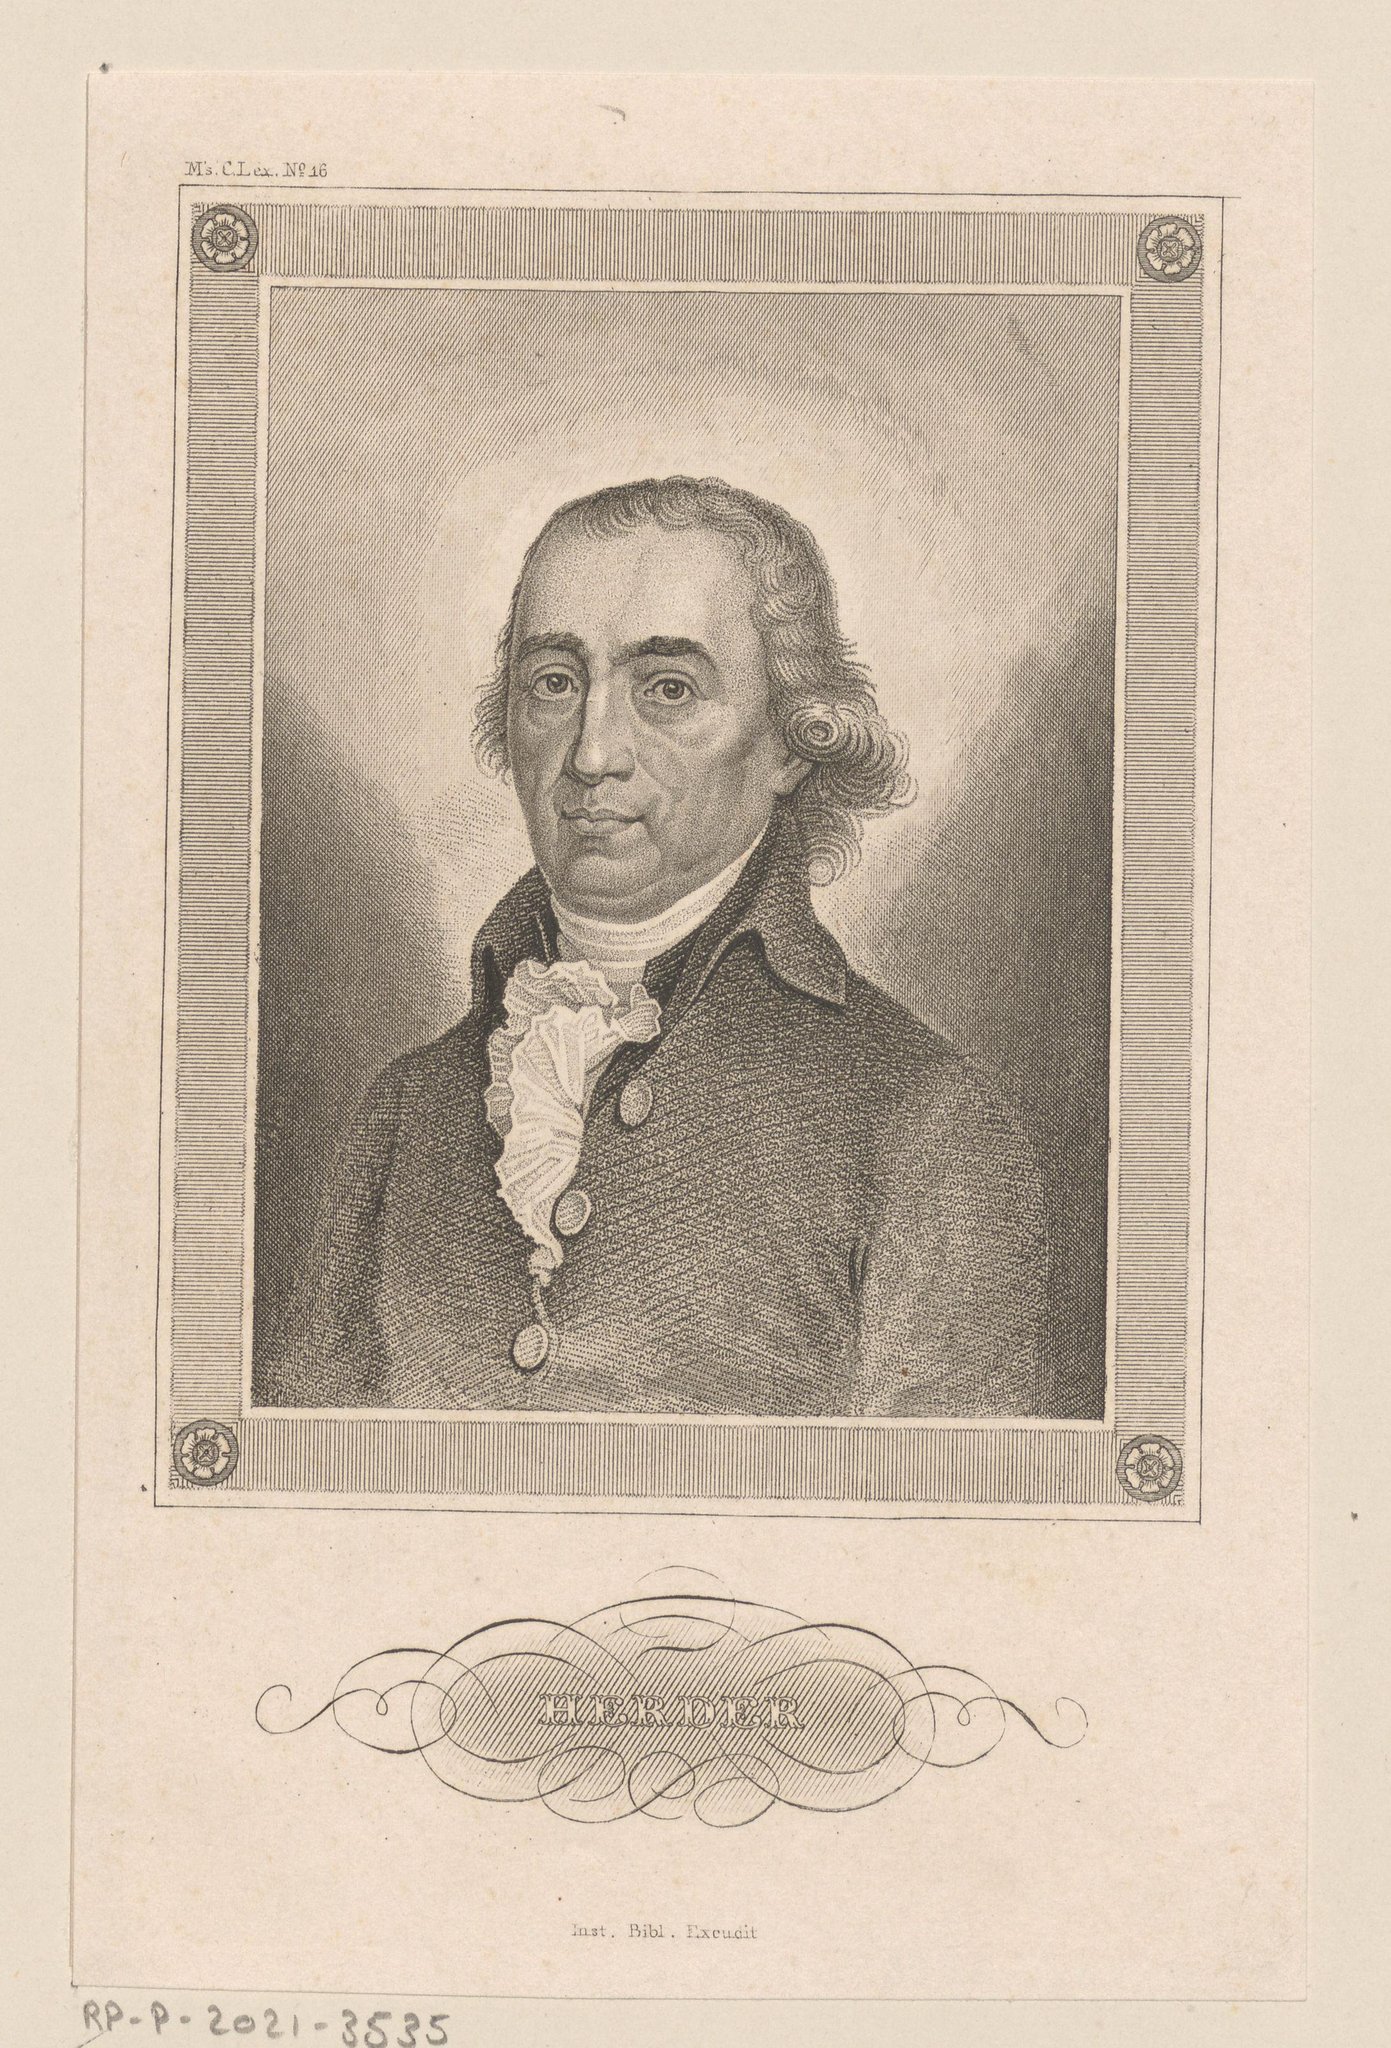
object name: book illustration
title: Portret van Johann Gottfried von Herder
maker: Anonymous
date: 1840-1855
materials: paper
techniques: engraving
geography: hildburghausen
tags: historical persons, writer, poet, author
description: Prent uit: Meyer, Joseph. Das Grosse Conversations-Lexikon für die gebildeten Stände. Hildburghausen: Bibliographisches Institut, 1840-1855.